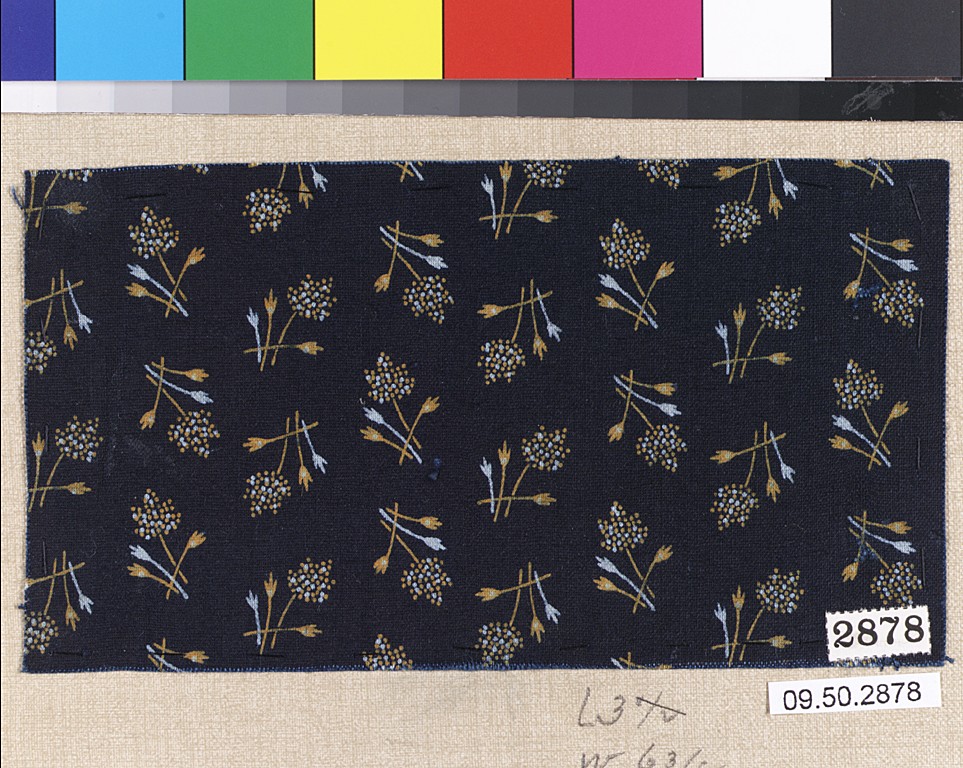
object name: piece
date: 1801-1900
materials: cotton